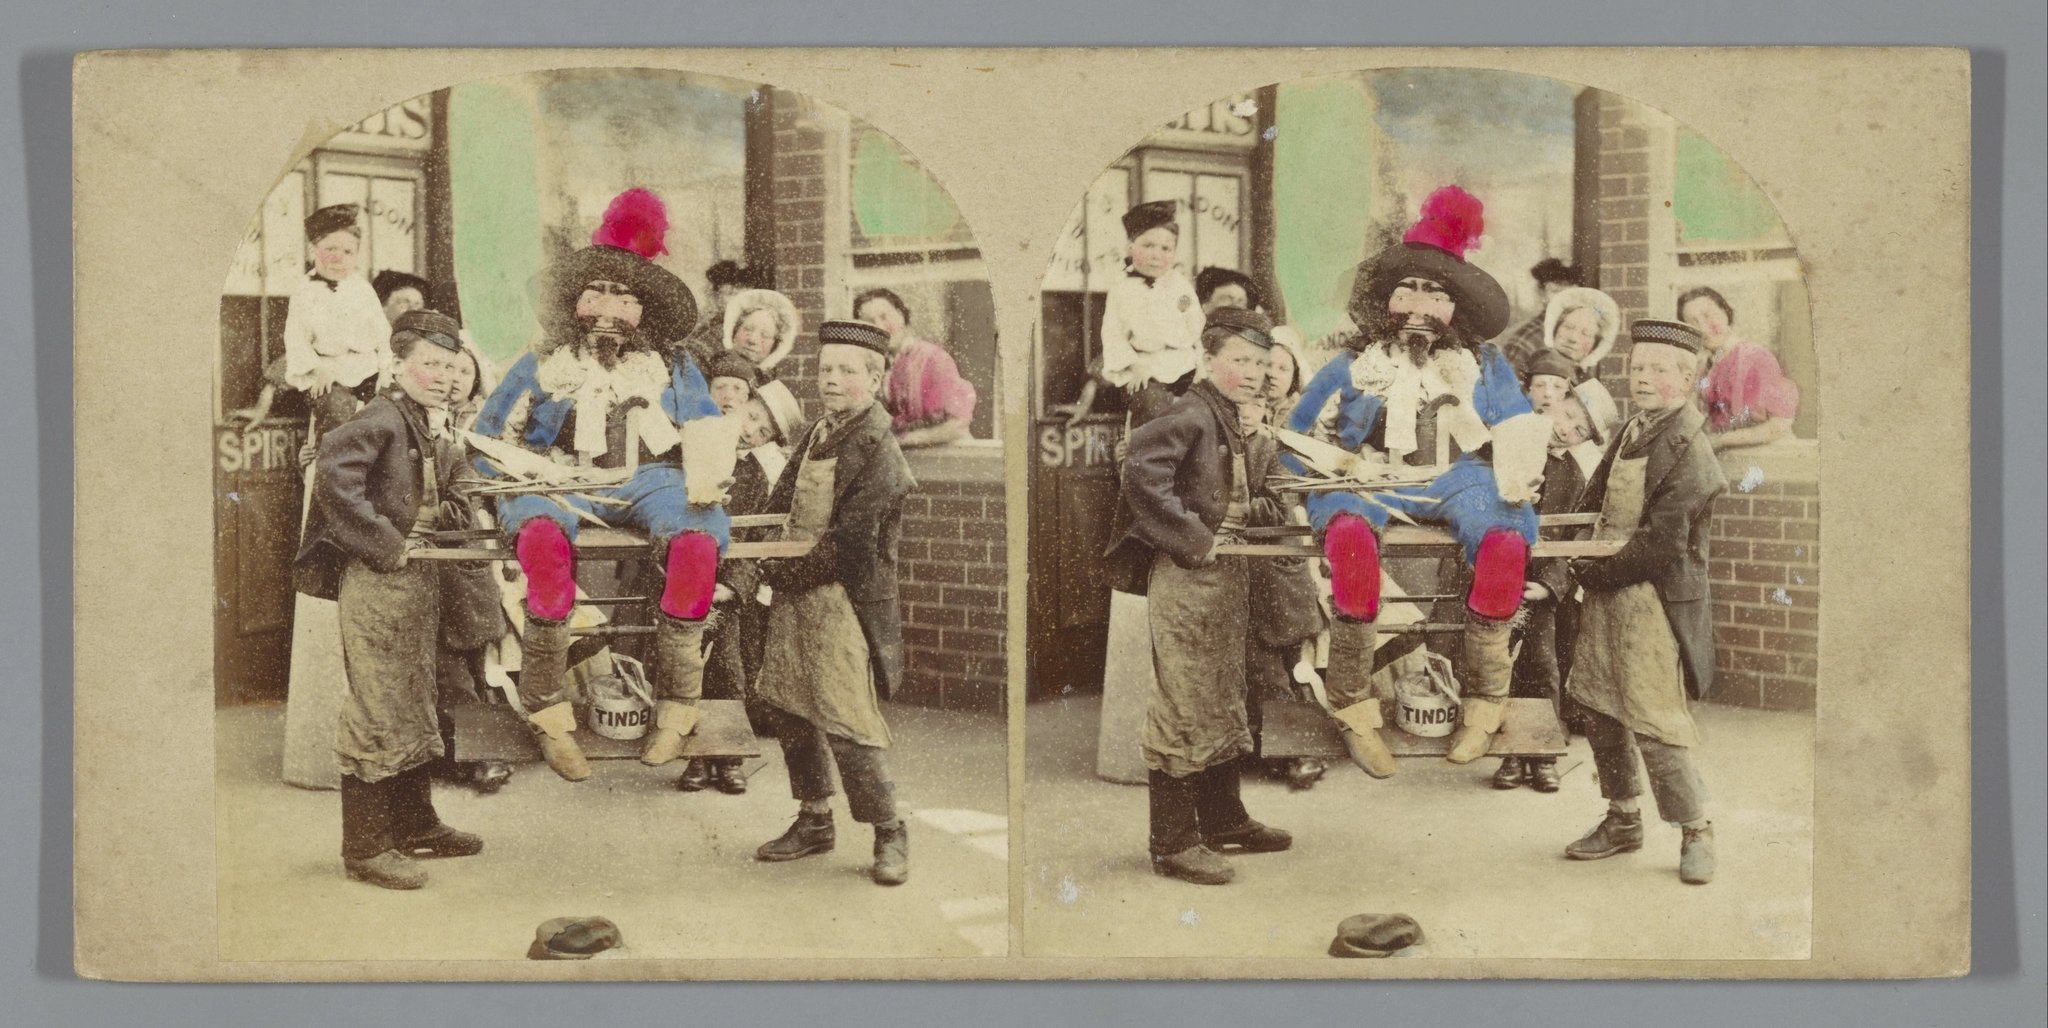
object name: stereograph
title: Verkleedpartij ter ere van Guy Fawkes Night, 5 november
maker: Anonymous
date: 1852-1863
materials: cardboard, paper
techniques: albumen print, hand coloring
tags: historical costume, public festivities